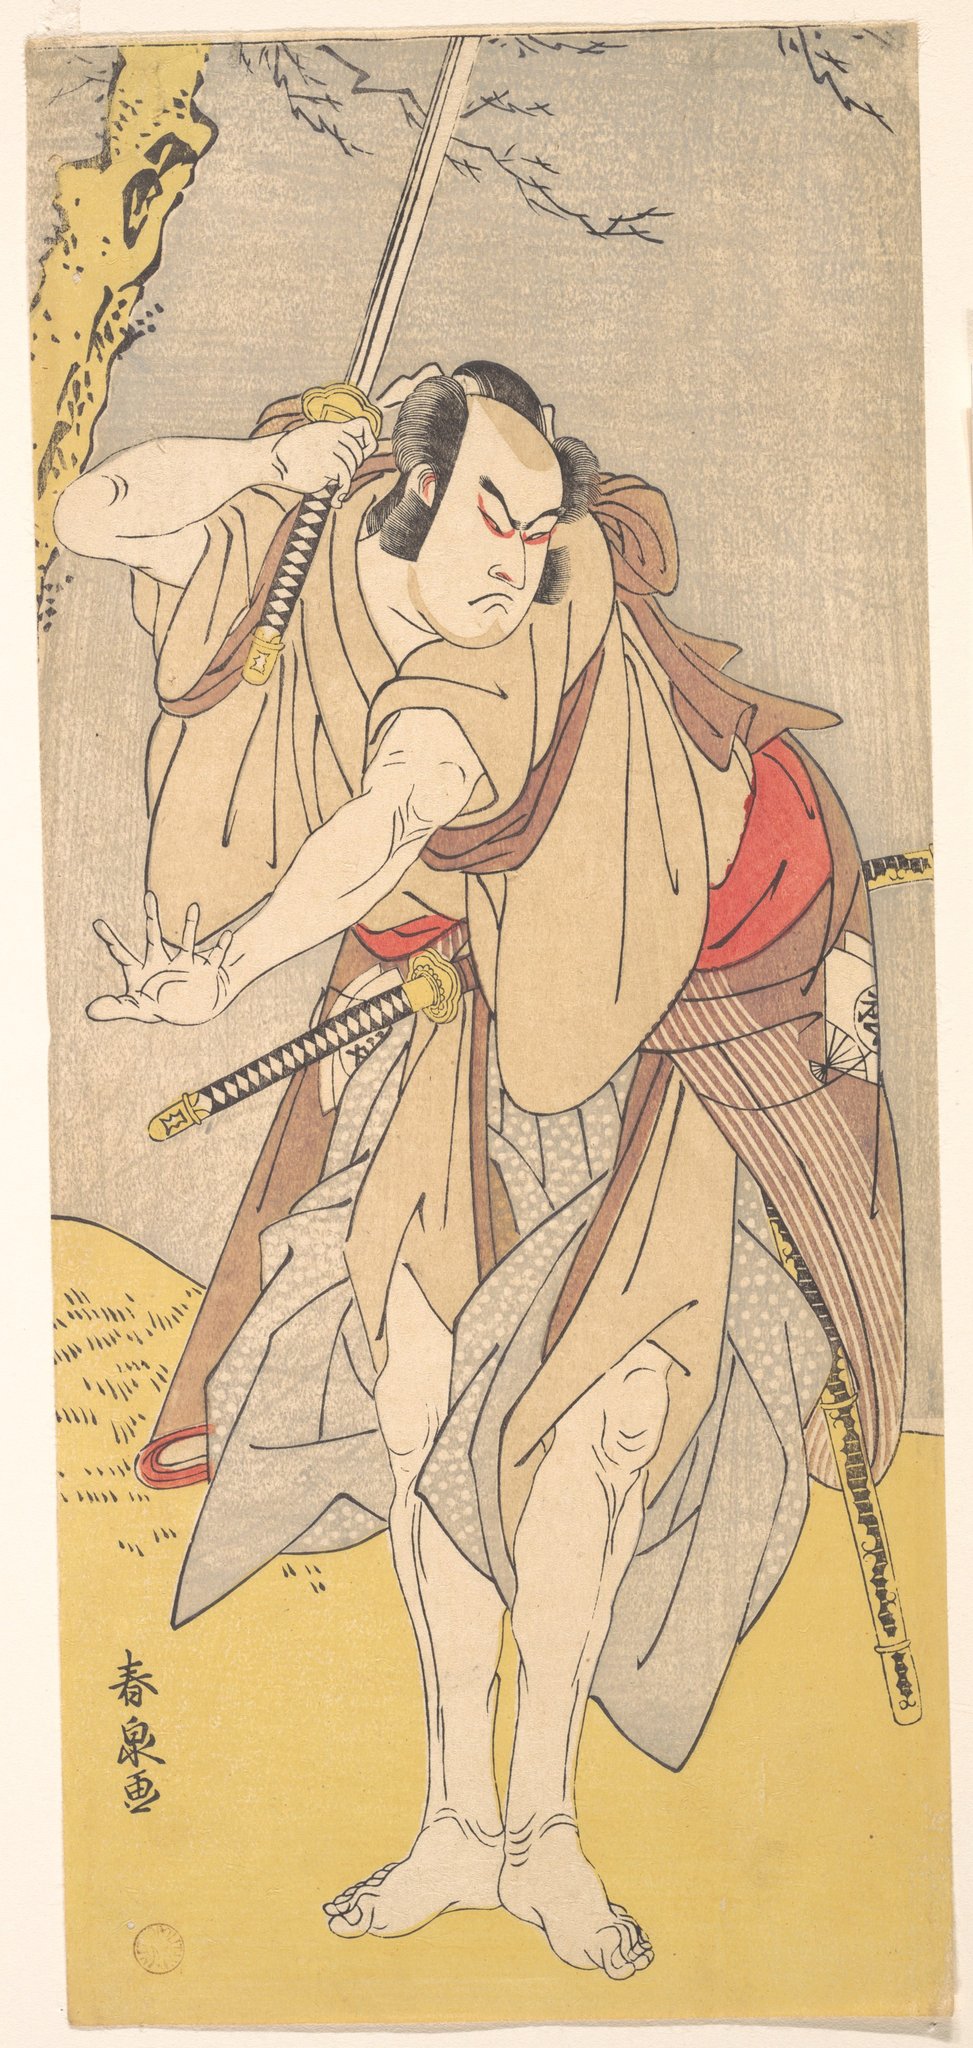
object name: print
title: The Actor Onoe Matsusuke as a Samurai with a Drawn Sword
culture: japanese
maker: katsukawa shunsen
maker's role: artist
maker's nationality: japanese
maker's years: 1762-1830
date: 1786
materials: ink, paper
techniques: woodblock print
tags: swords,men,actors